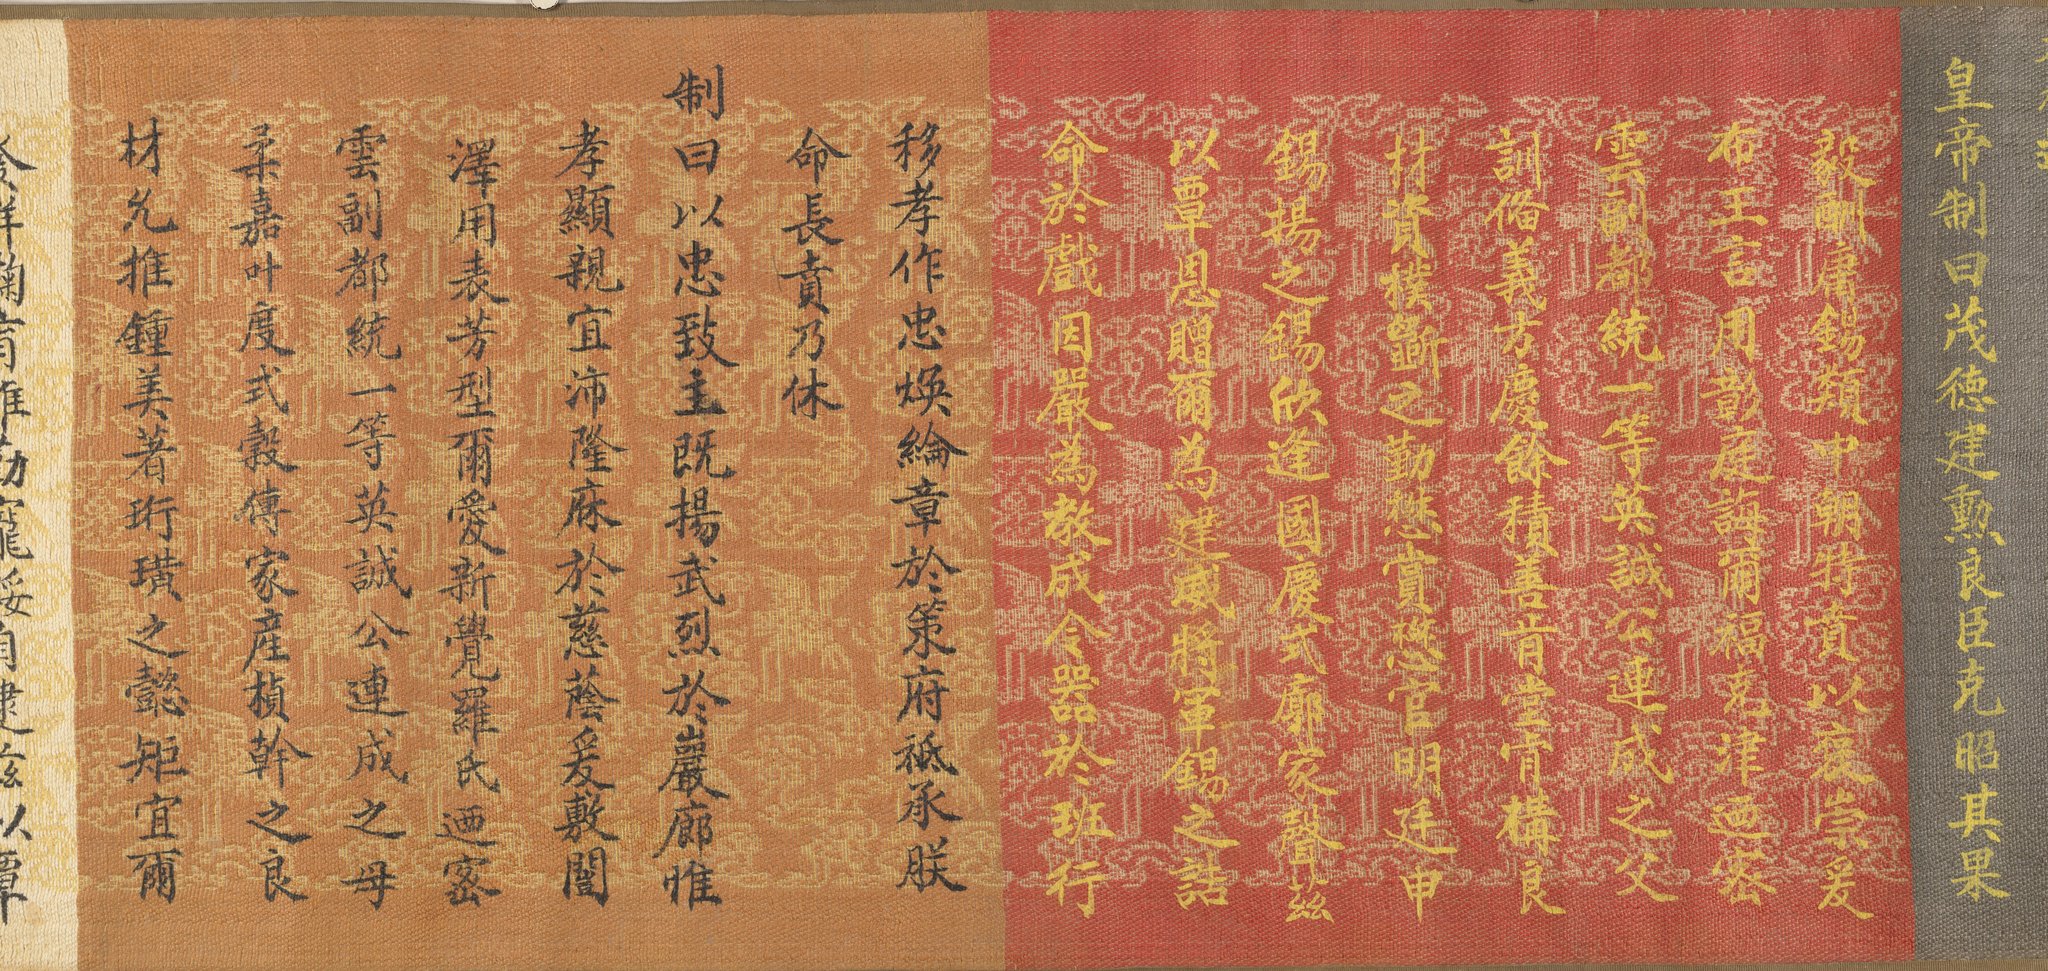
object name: handscroll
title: Scroll of Commission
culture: chinese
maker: unidentified artist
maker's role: artist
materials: silk